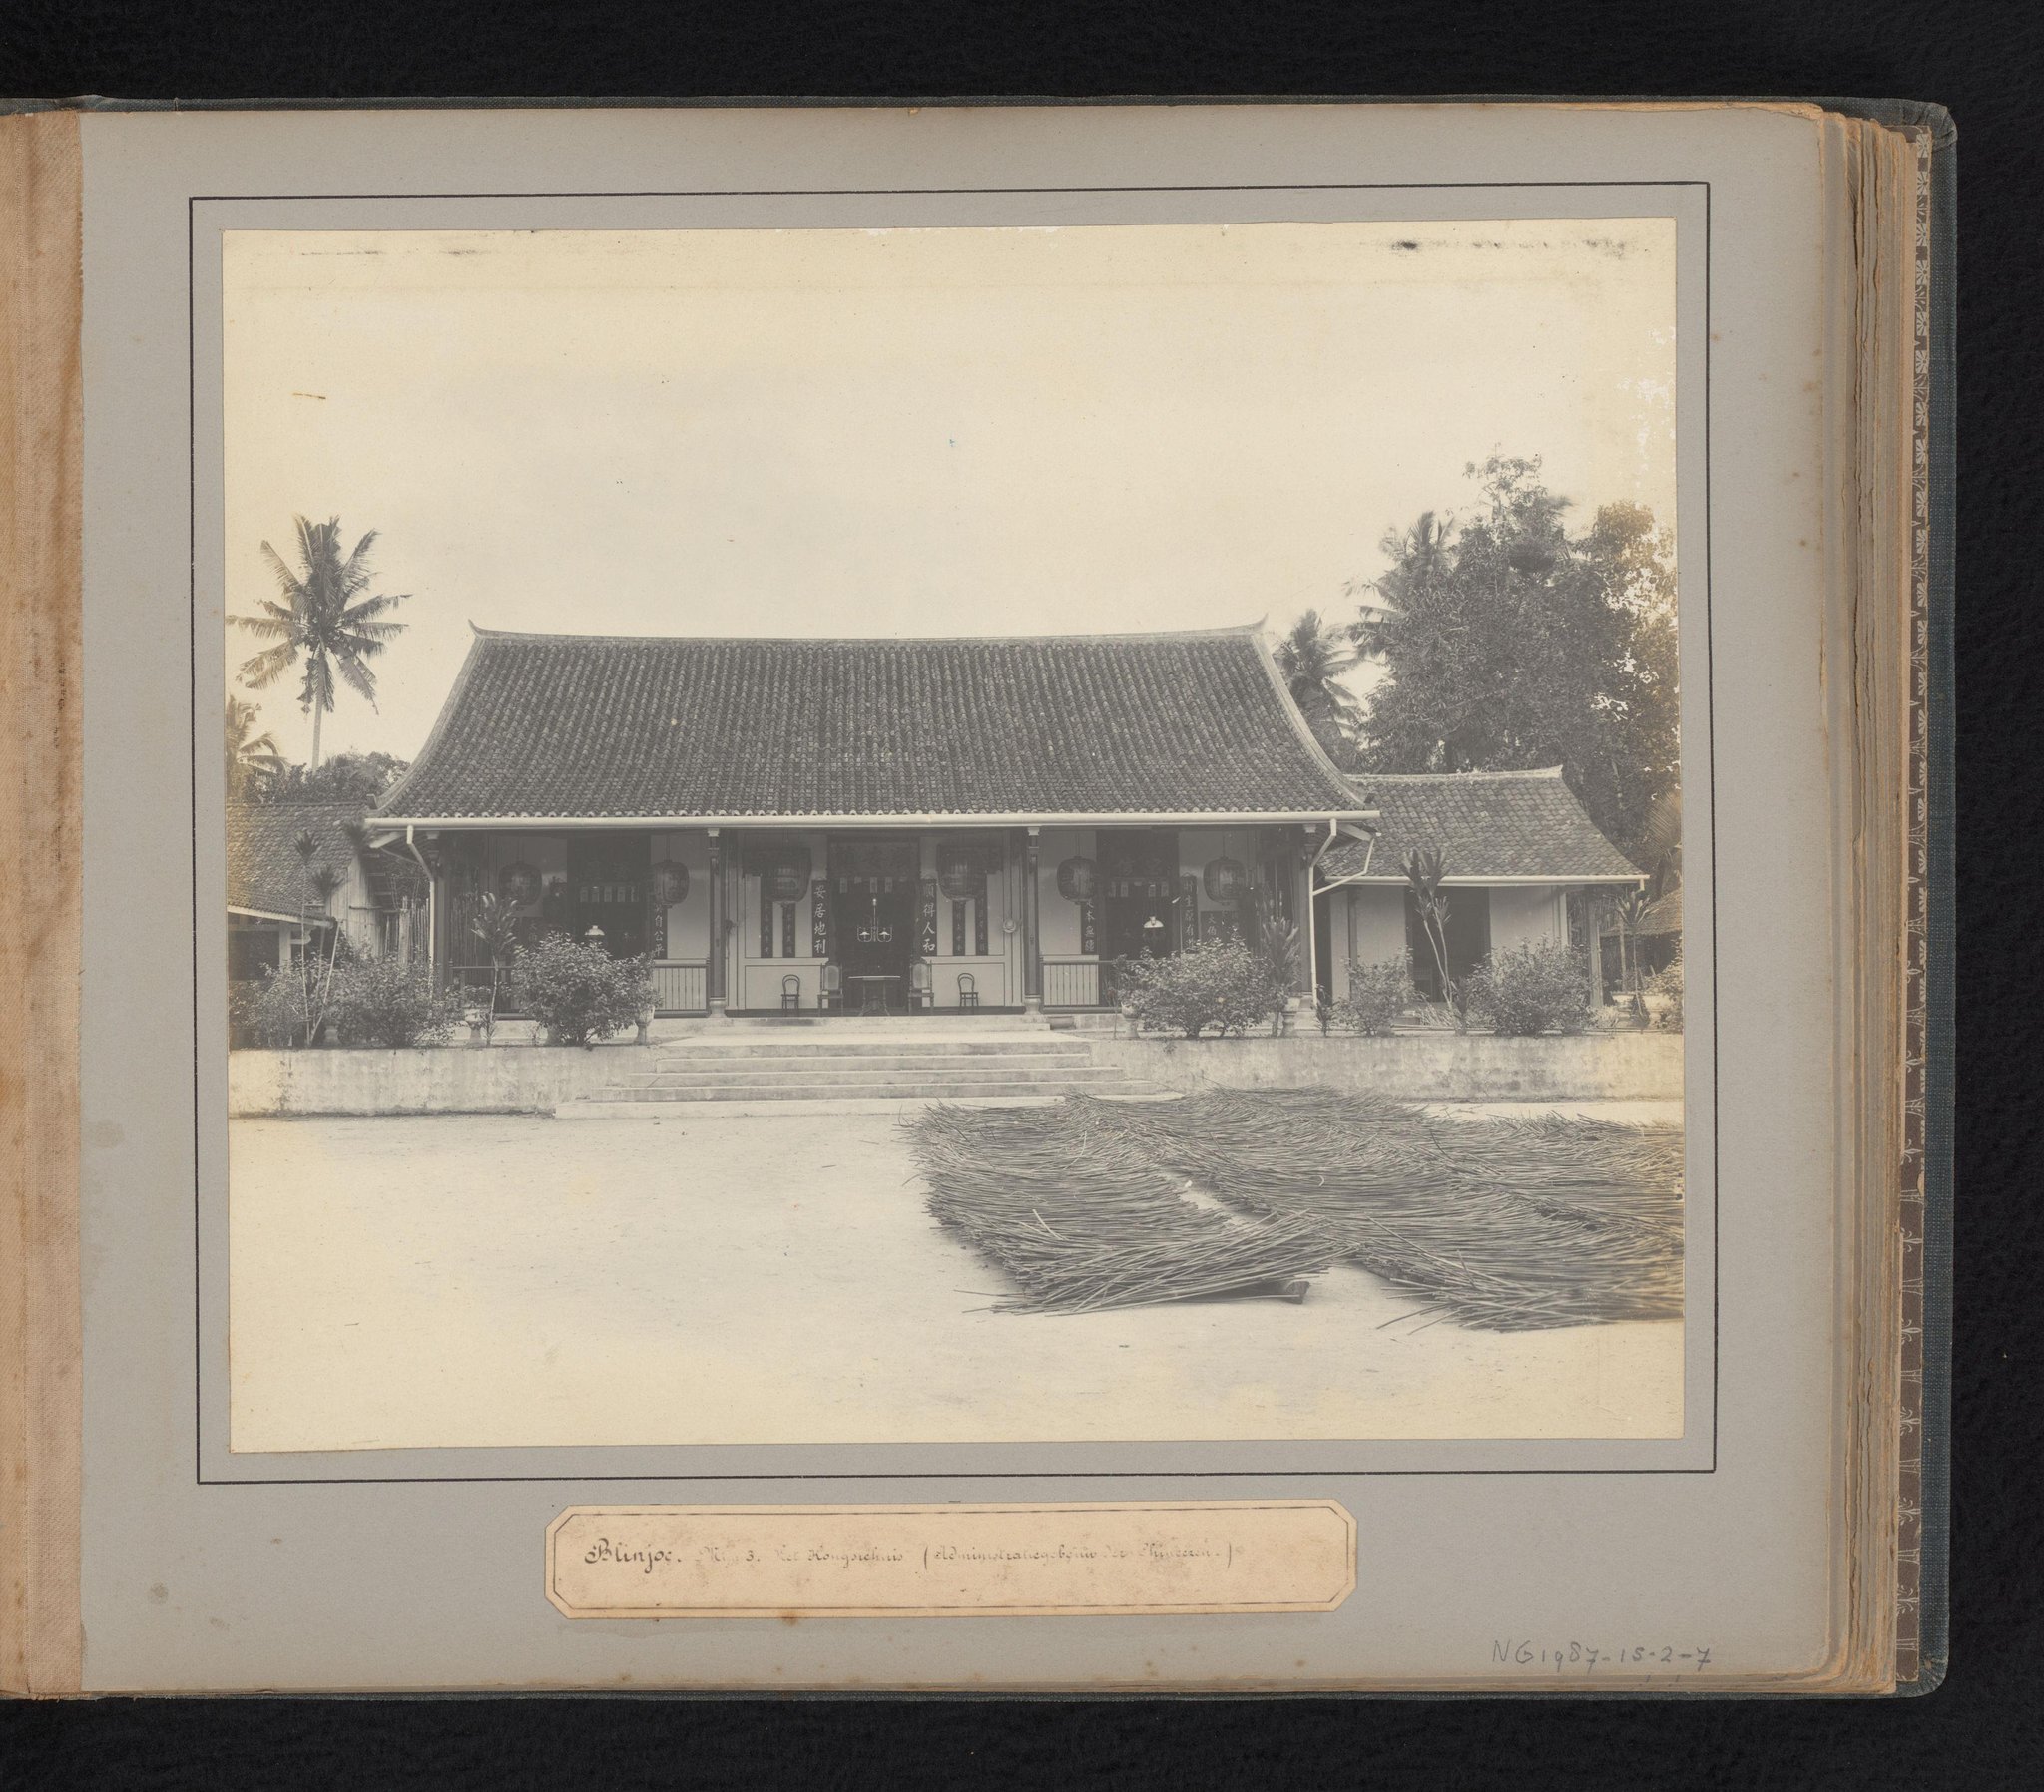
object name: photograph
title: Blinjoe. Mijn 3. Het Kongsihuis (Administratiegebouw der Chineezen.)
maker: Anonymous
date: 1907-1919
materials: cardboard, photographic support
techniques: gelatin silver print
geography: bangka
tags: robert julius boers, colonial system, opencast mine; strip mining, miner, minerals and metals: tin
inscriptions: label: ‘Blinjoe. Mijn 3. Het Kongsihuis (Administratiegebouw der Chineezen.)’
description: Kongsihuis, een verenigingshuis voor Chinese mijnwerkers van de Banka-tinwinning te Belinyu (Blinjoe). Onderdeel van het fotoalbum over de Banka-tinwinning, ca. 1907-1919.